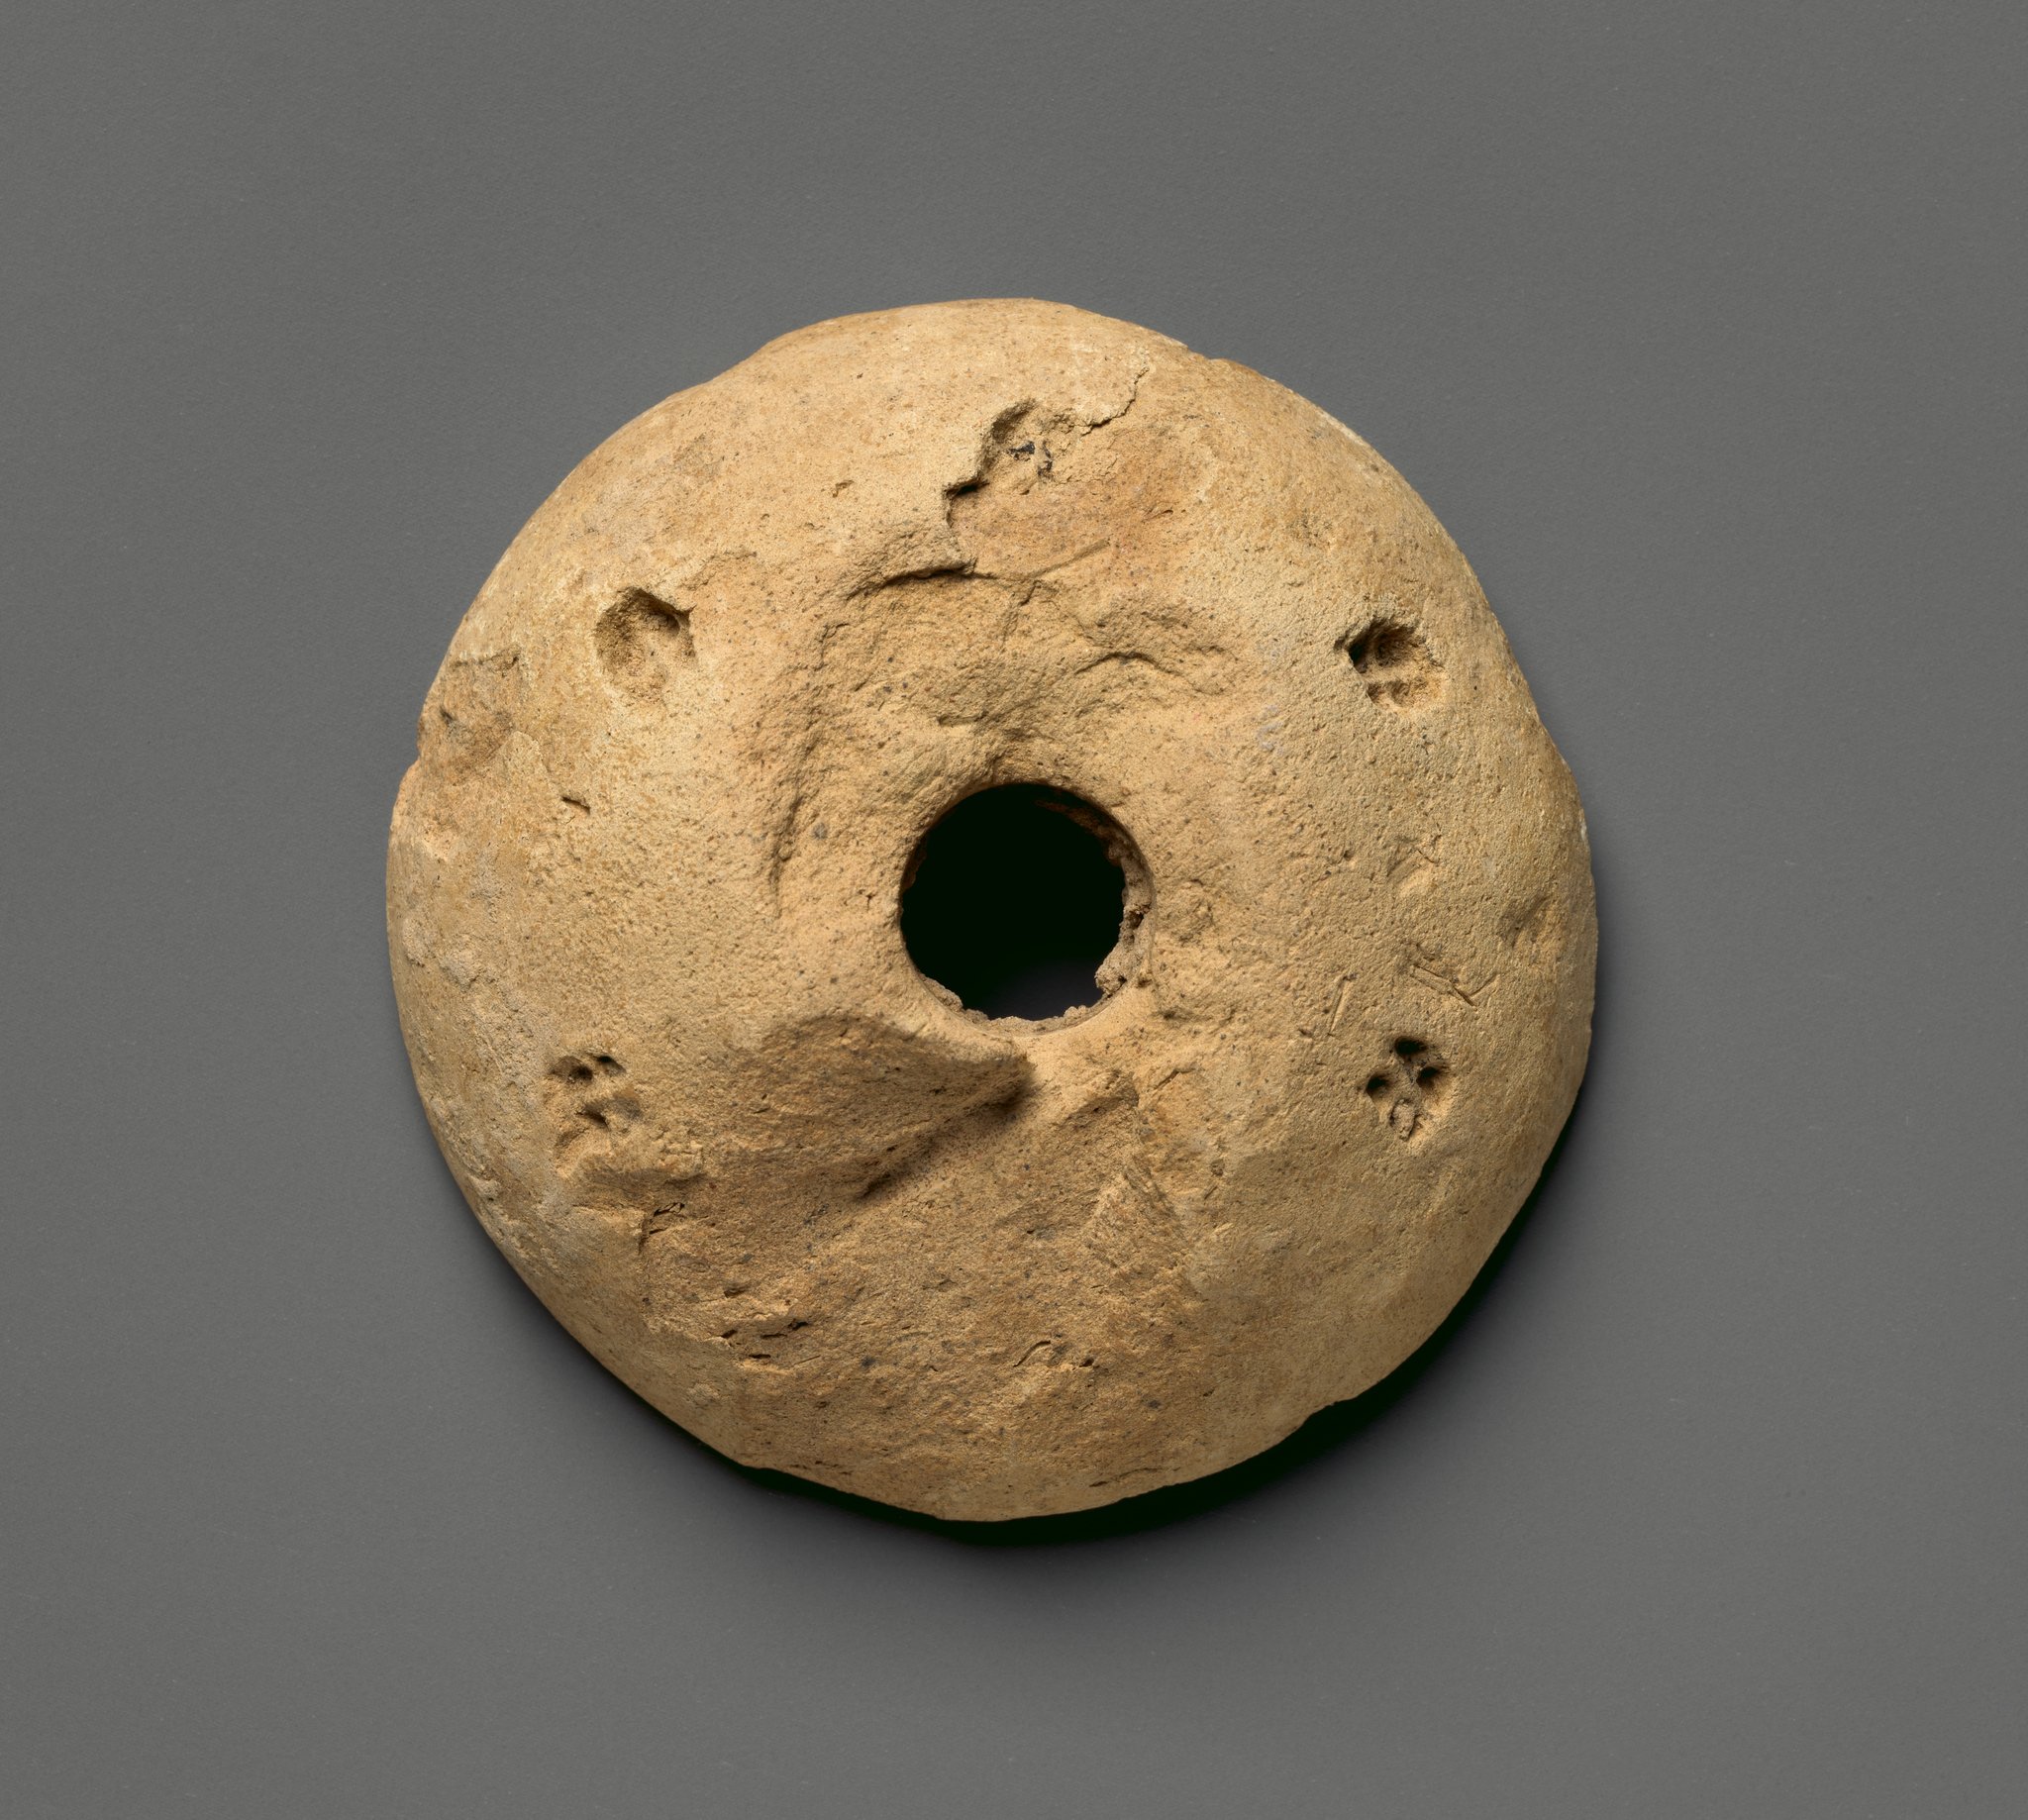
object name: whorl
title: Spindle whorl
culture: sumerian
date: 2900-2600 BCE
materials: ceramic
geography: mesopotamia